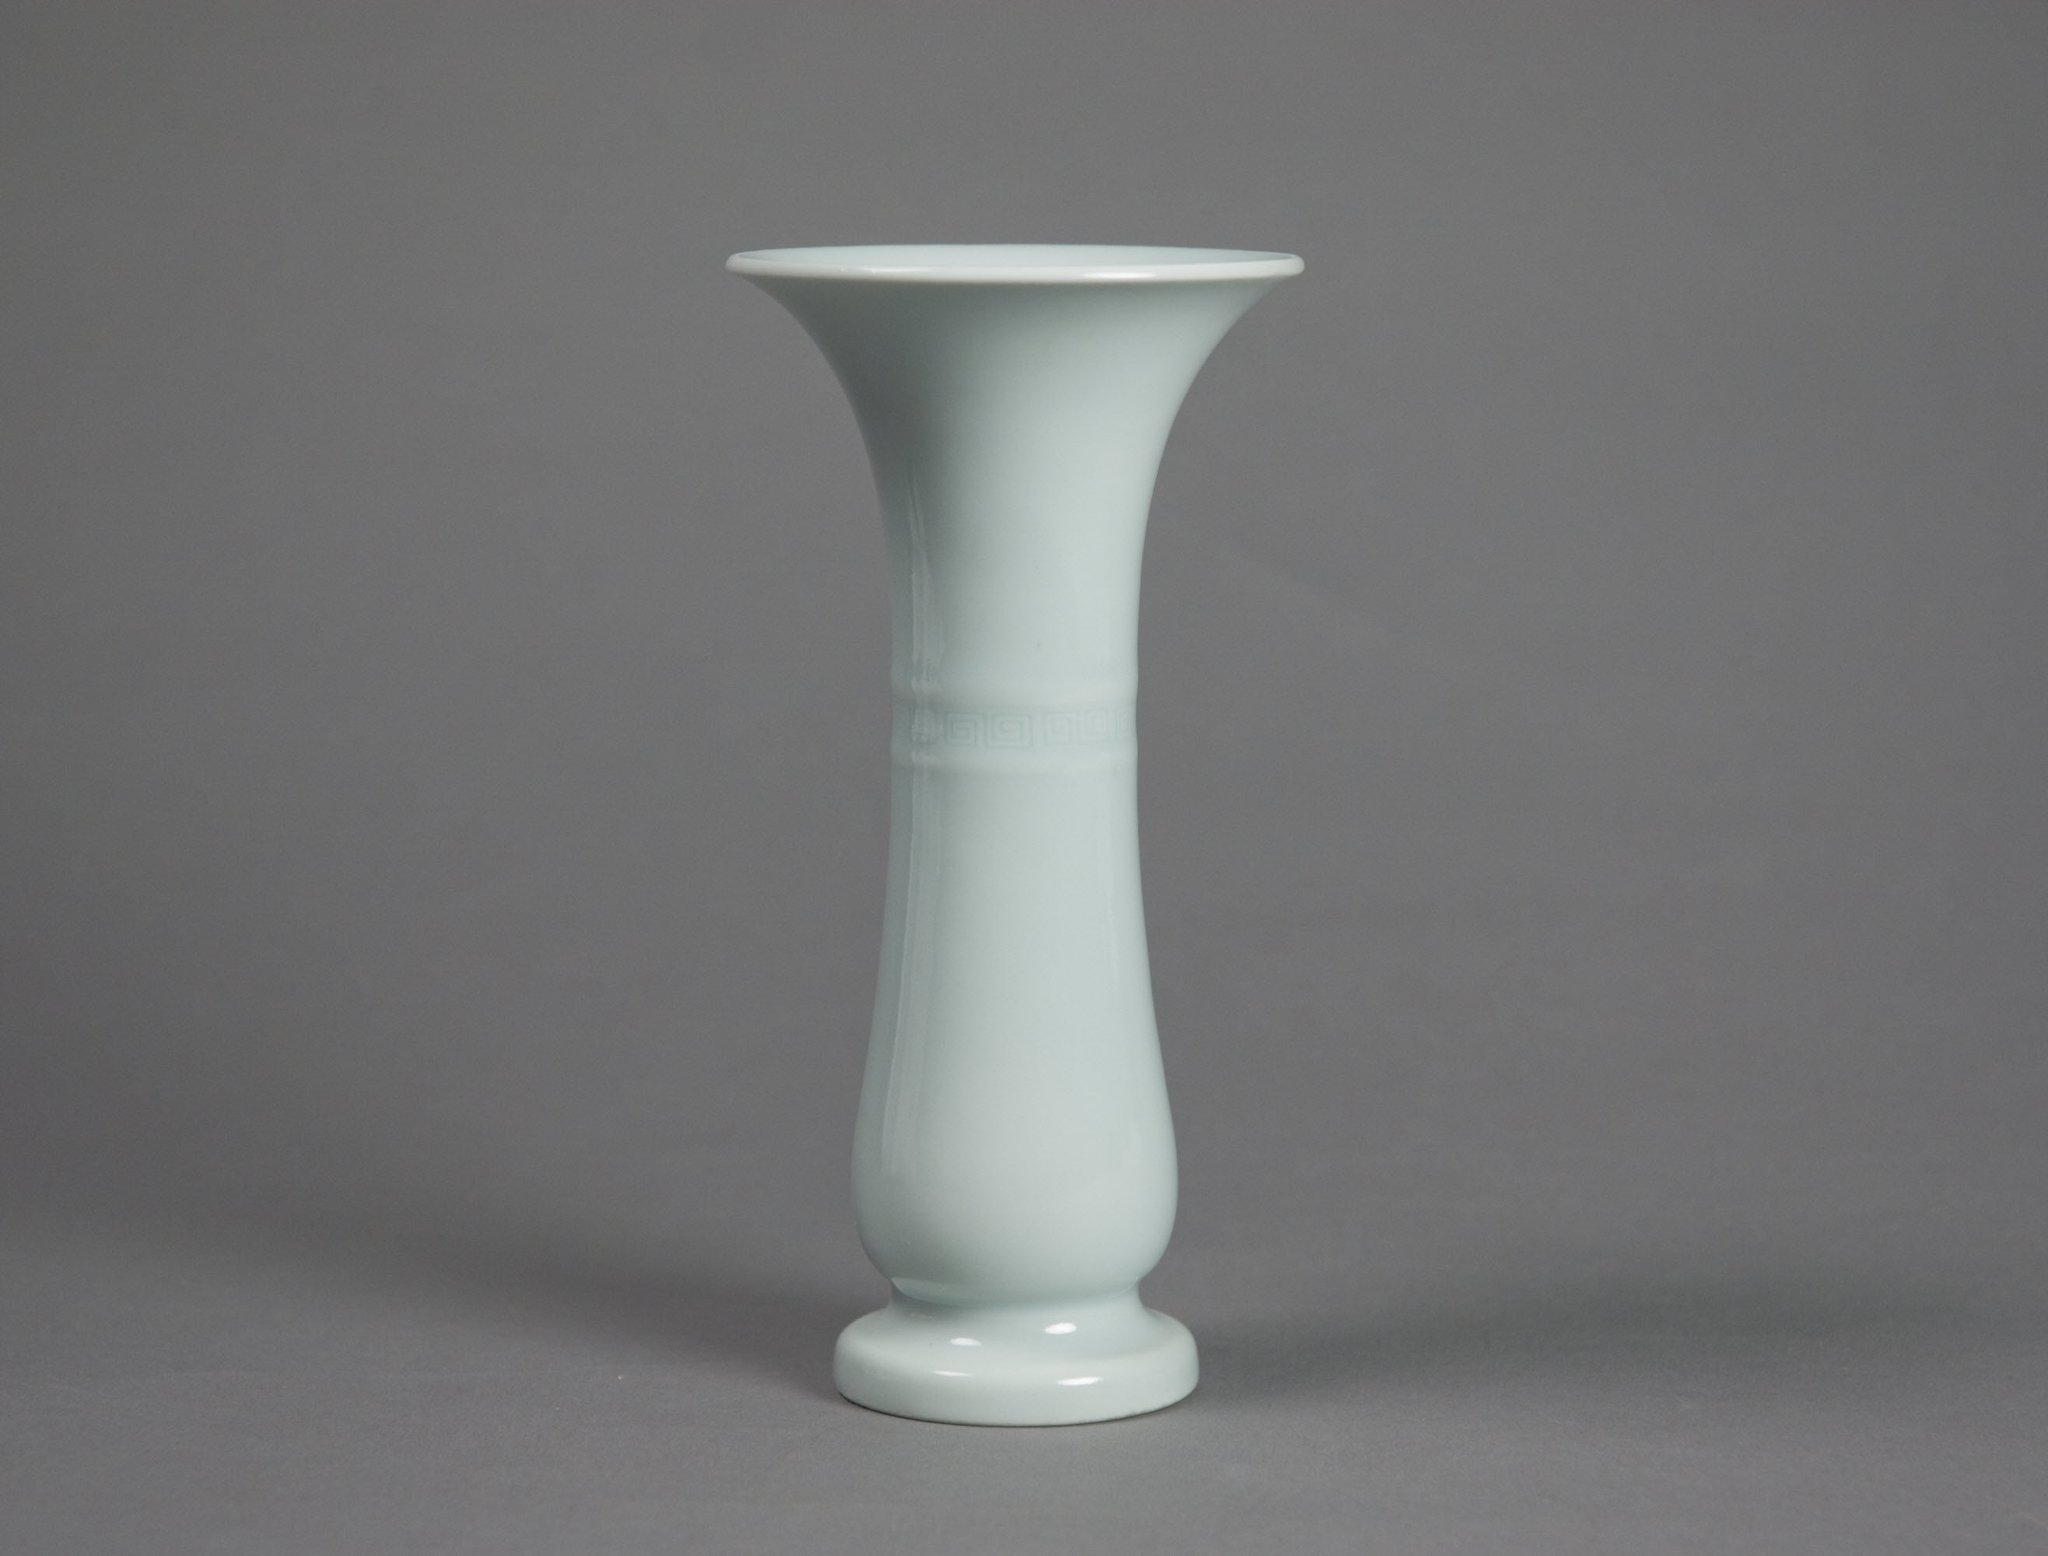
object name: vase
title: Vase in the shape of an ancient ritual cup (zhi) (one of a pair)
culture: chinese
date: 1736-1795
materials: glaze, porcelain